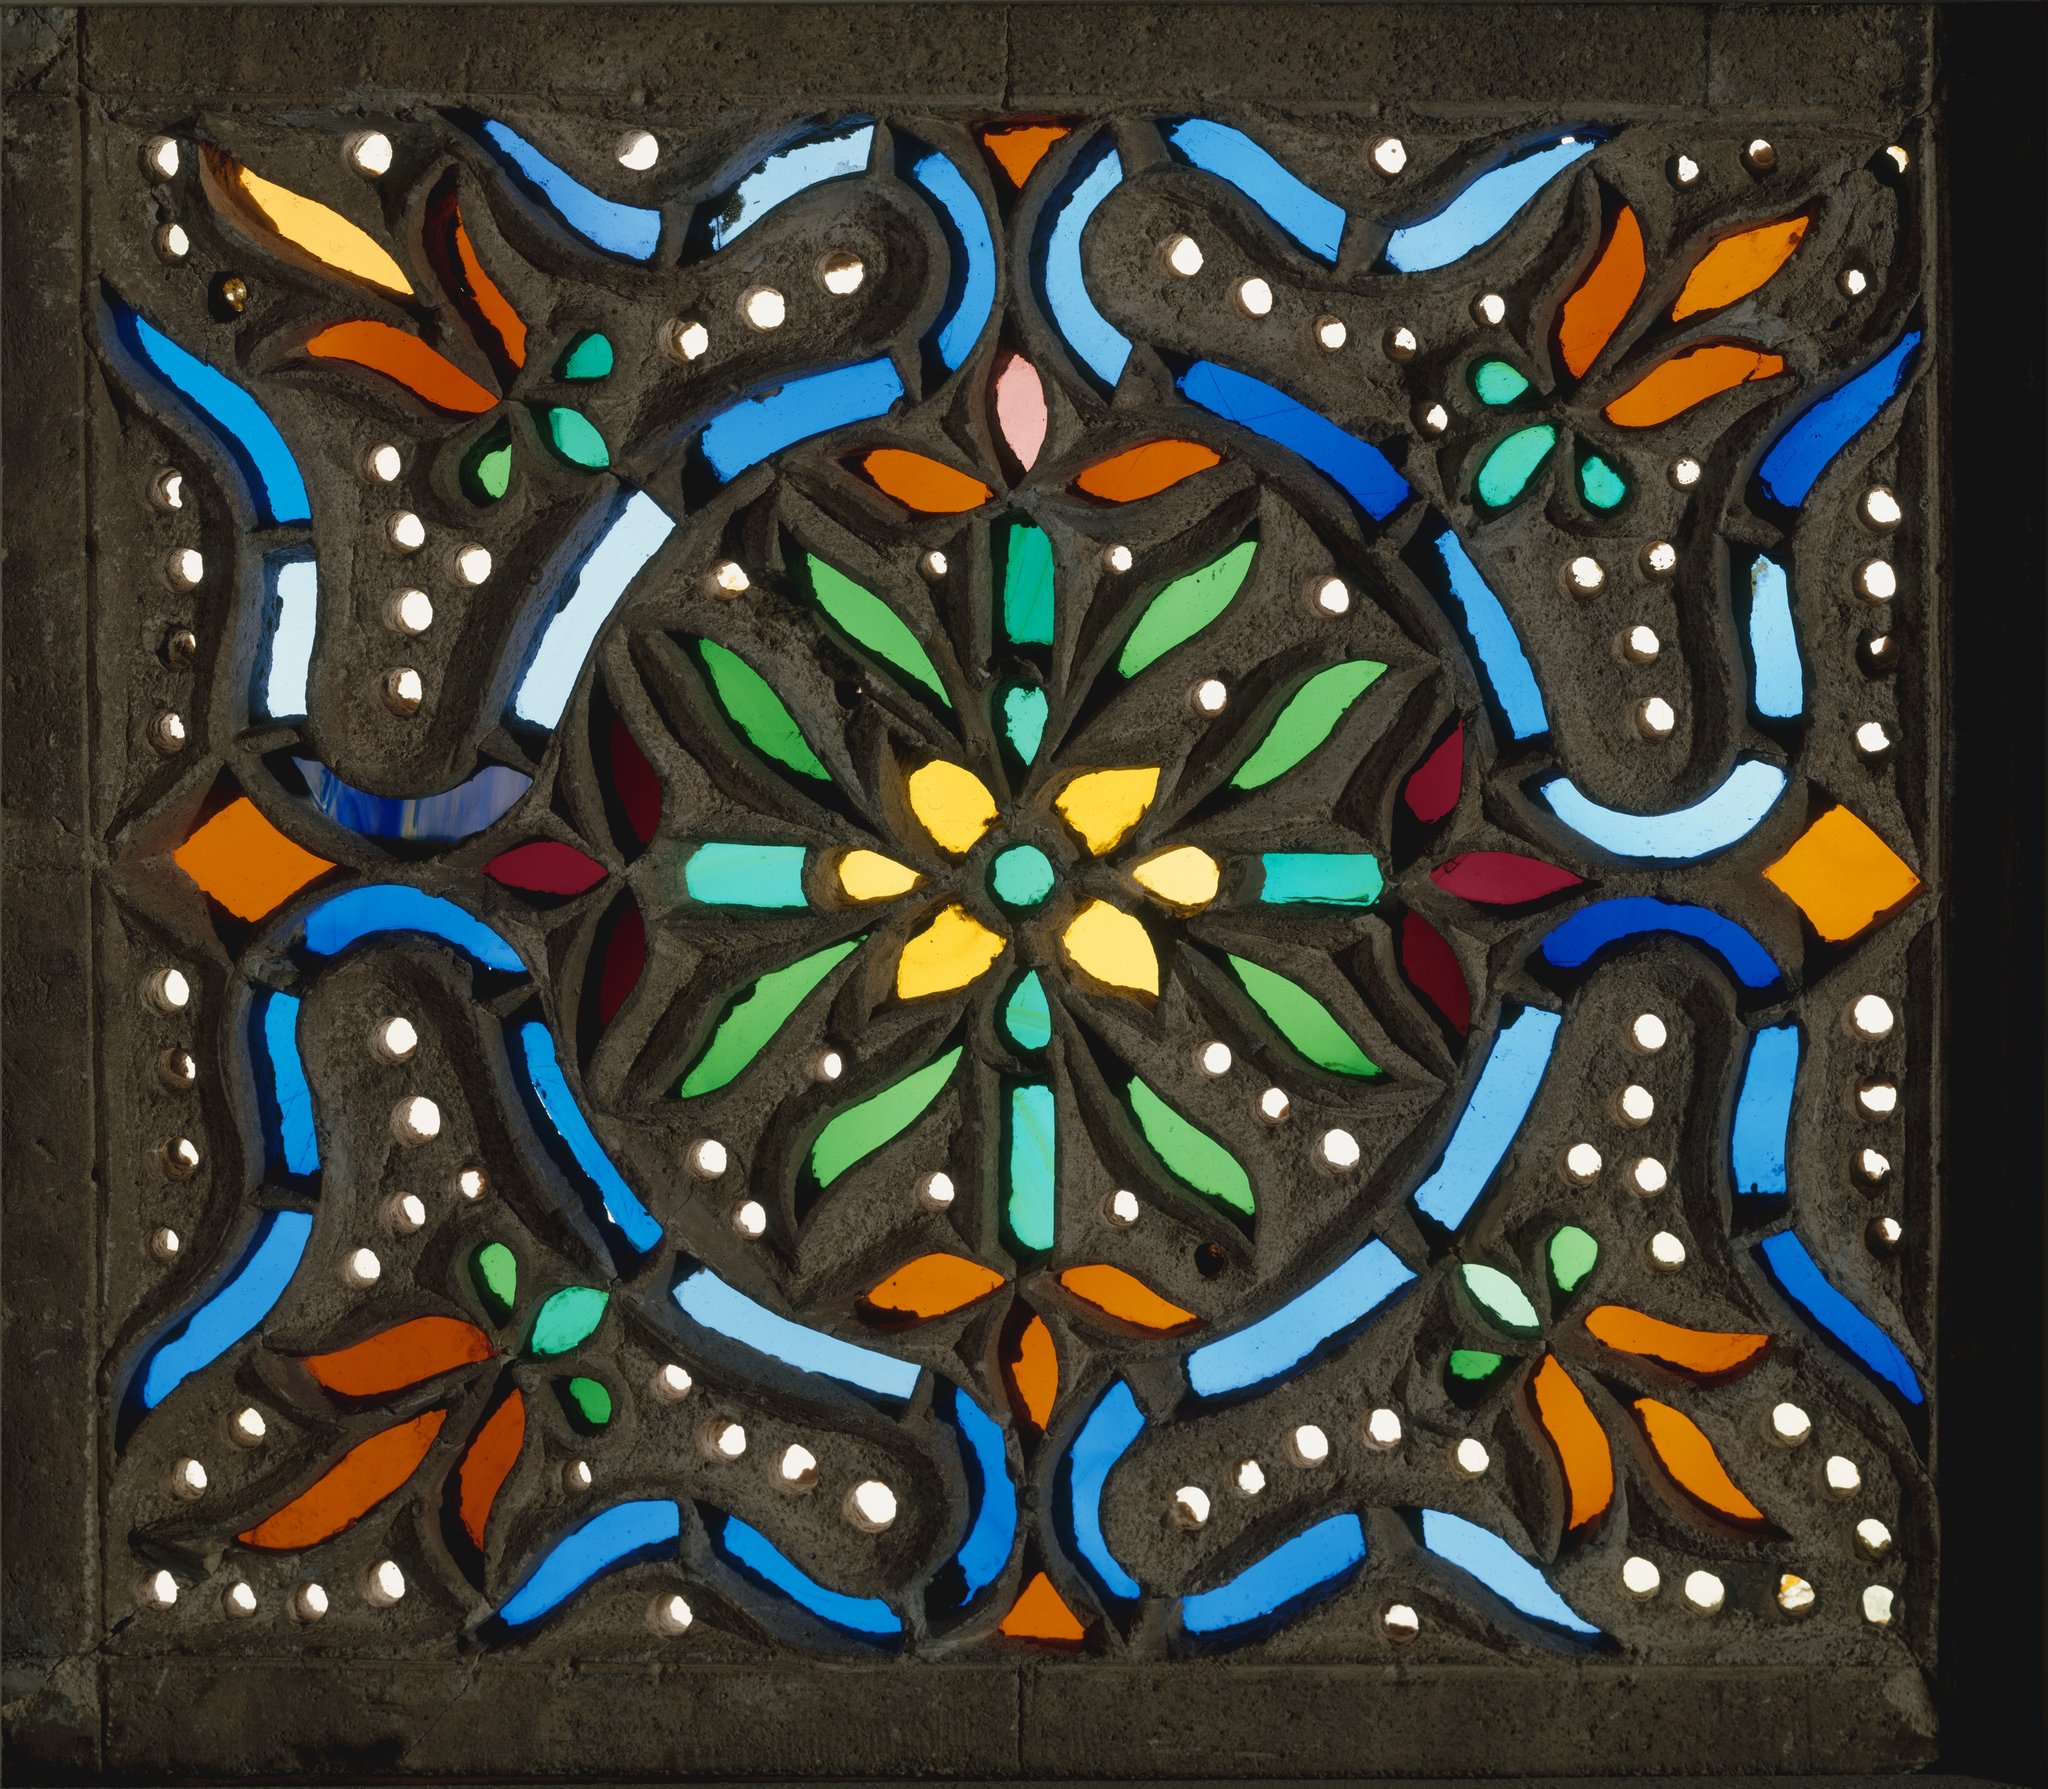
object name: window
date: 1701-1800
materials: gypsum, glass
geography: egypt or syria